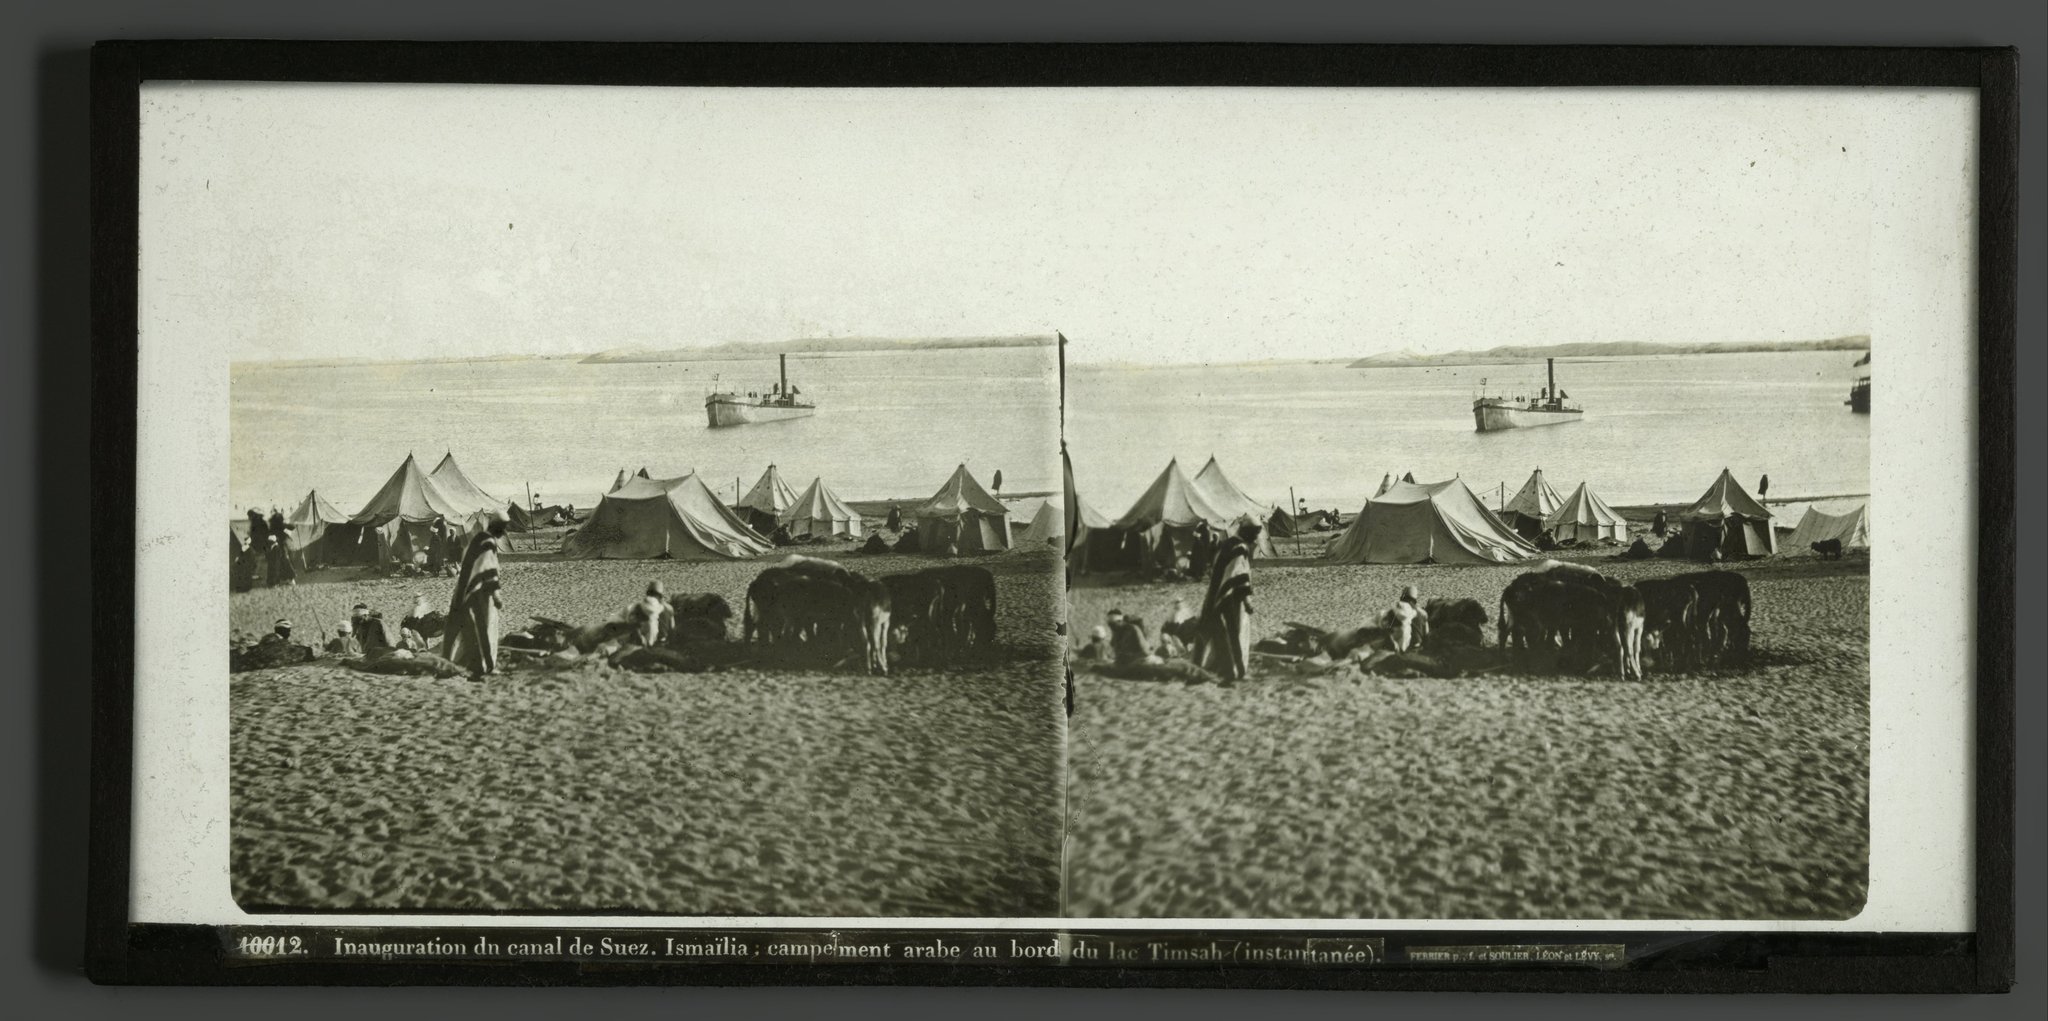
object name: stereoscopic photograph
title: Gezicht op een kamp op het strand van het Timsahmeer, Egypte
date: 1869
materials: glass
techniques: slide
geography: ismailia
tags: lake, tent-camp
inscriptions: number: ‘10012’